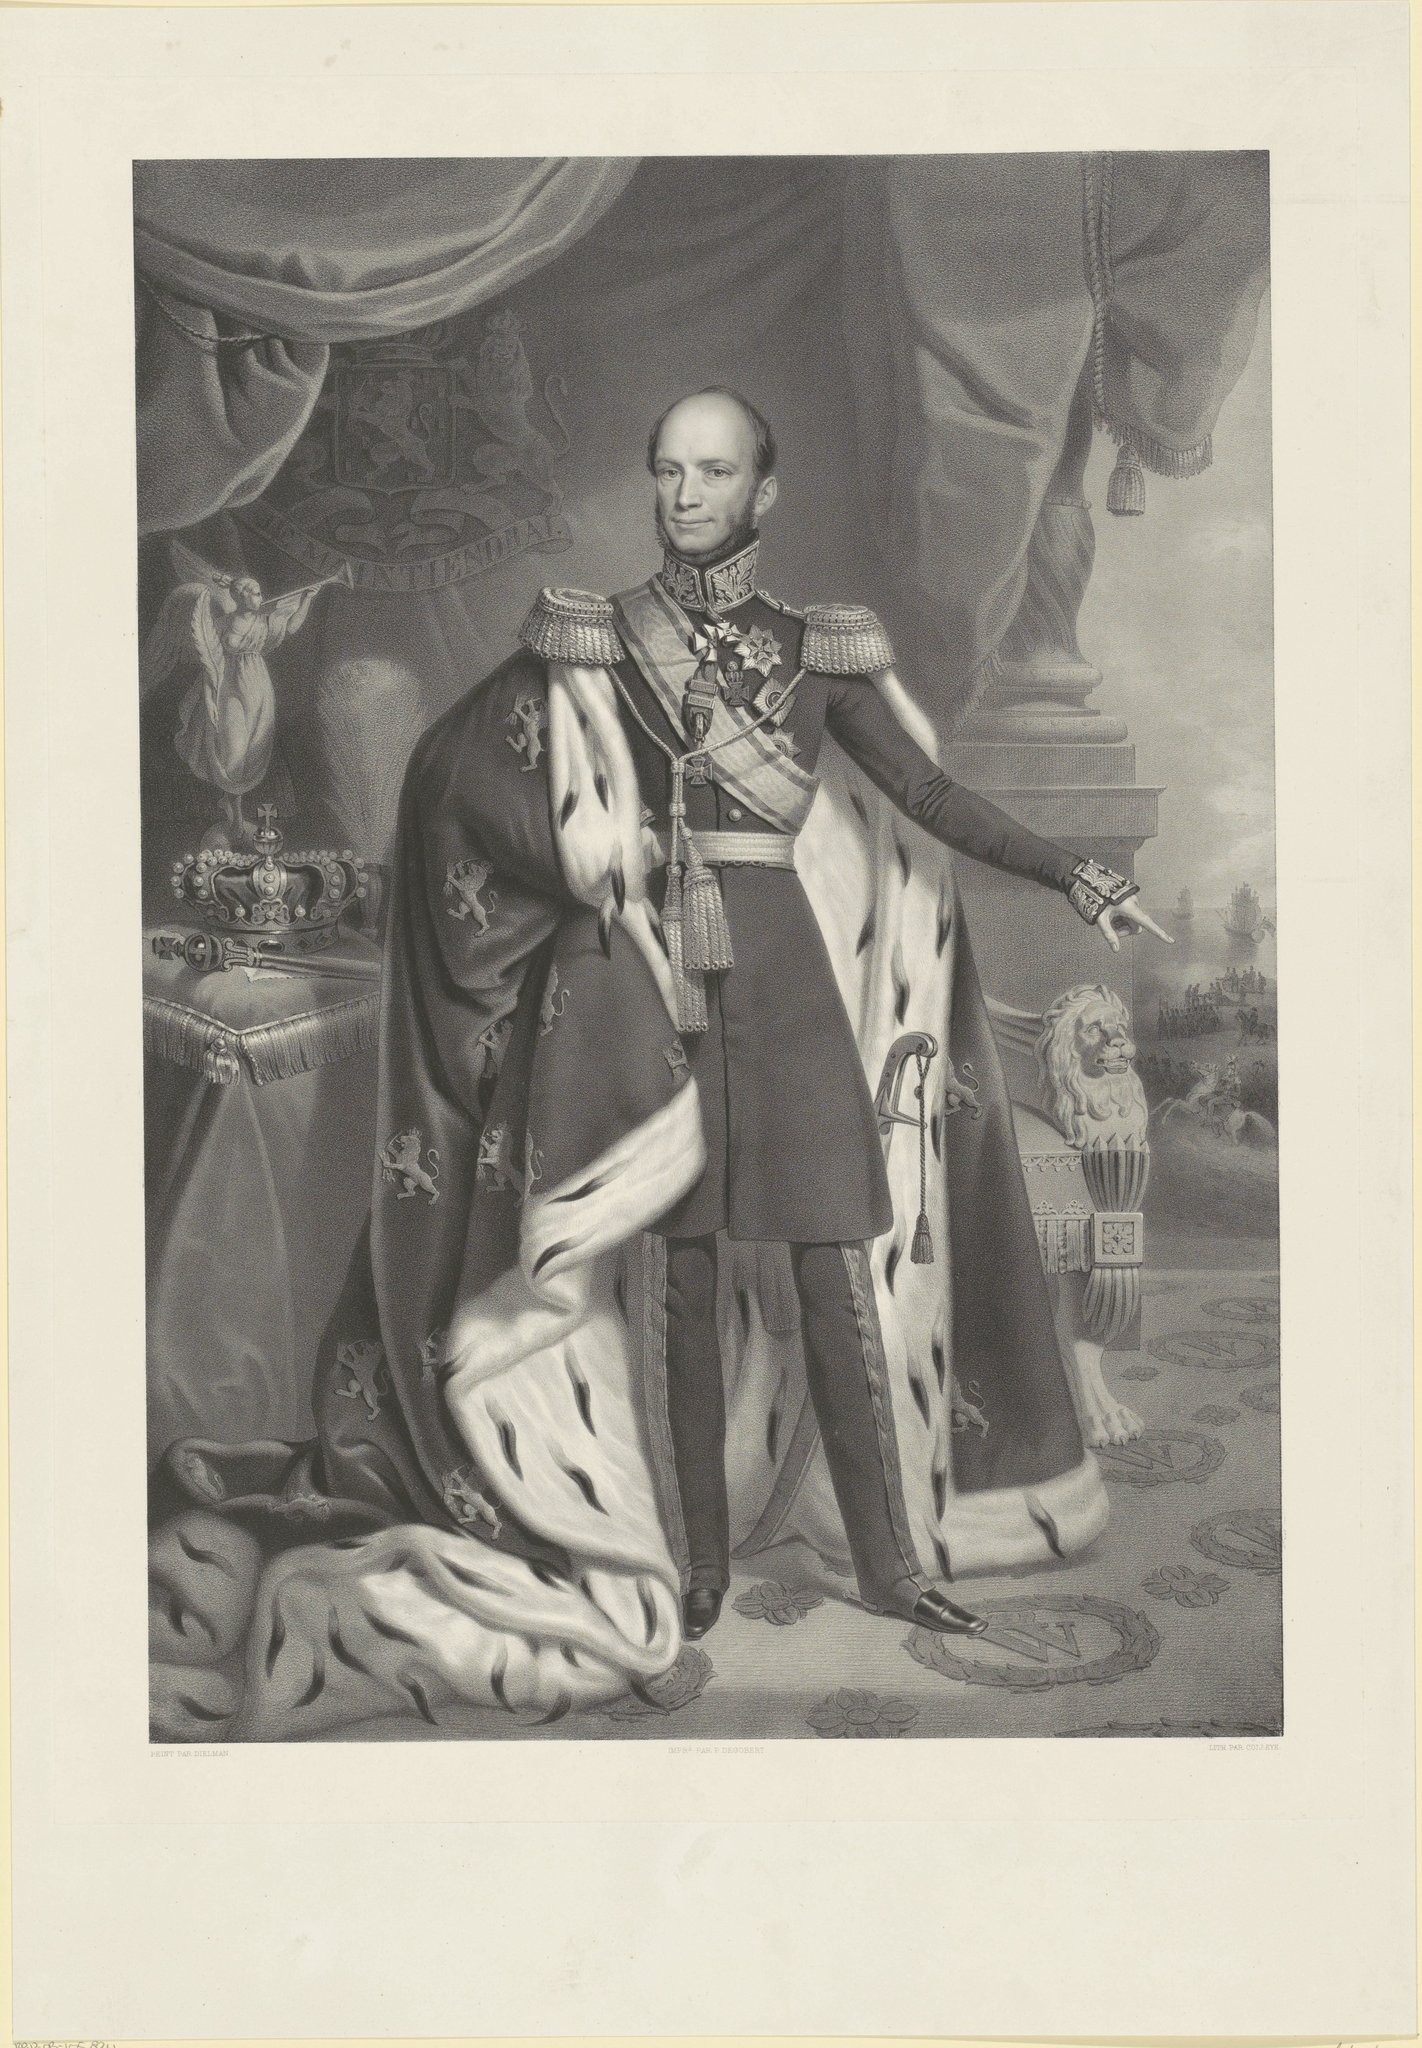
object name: print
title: Portret van Willem II, koning der Nederlanden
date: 1840-1849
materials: paper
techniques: lithograph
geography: brussels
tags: william ii of the netherlands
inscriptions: collector's mark: Lugt 963, collector's mark: Lugt 2165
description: Portret van Willem II met een hermelijnen mantel. Hij staat in een vertrek naast een tafel met daarop een kroon en een scepter. Rechts een doorkijkje naar militaire troepen en de zee.